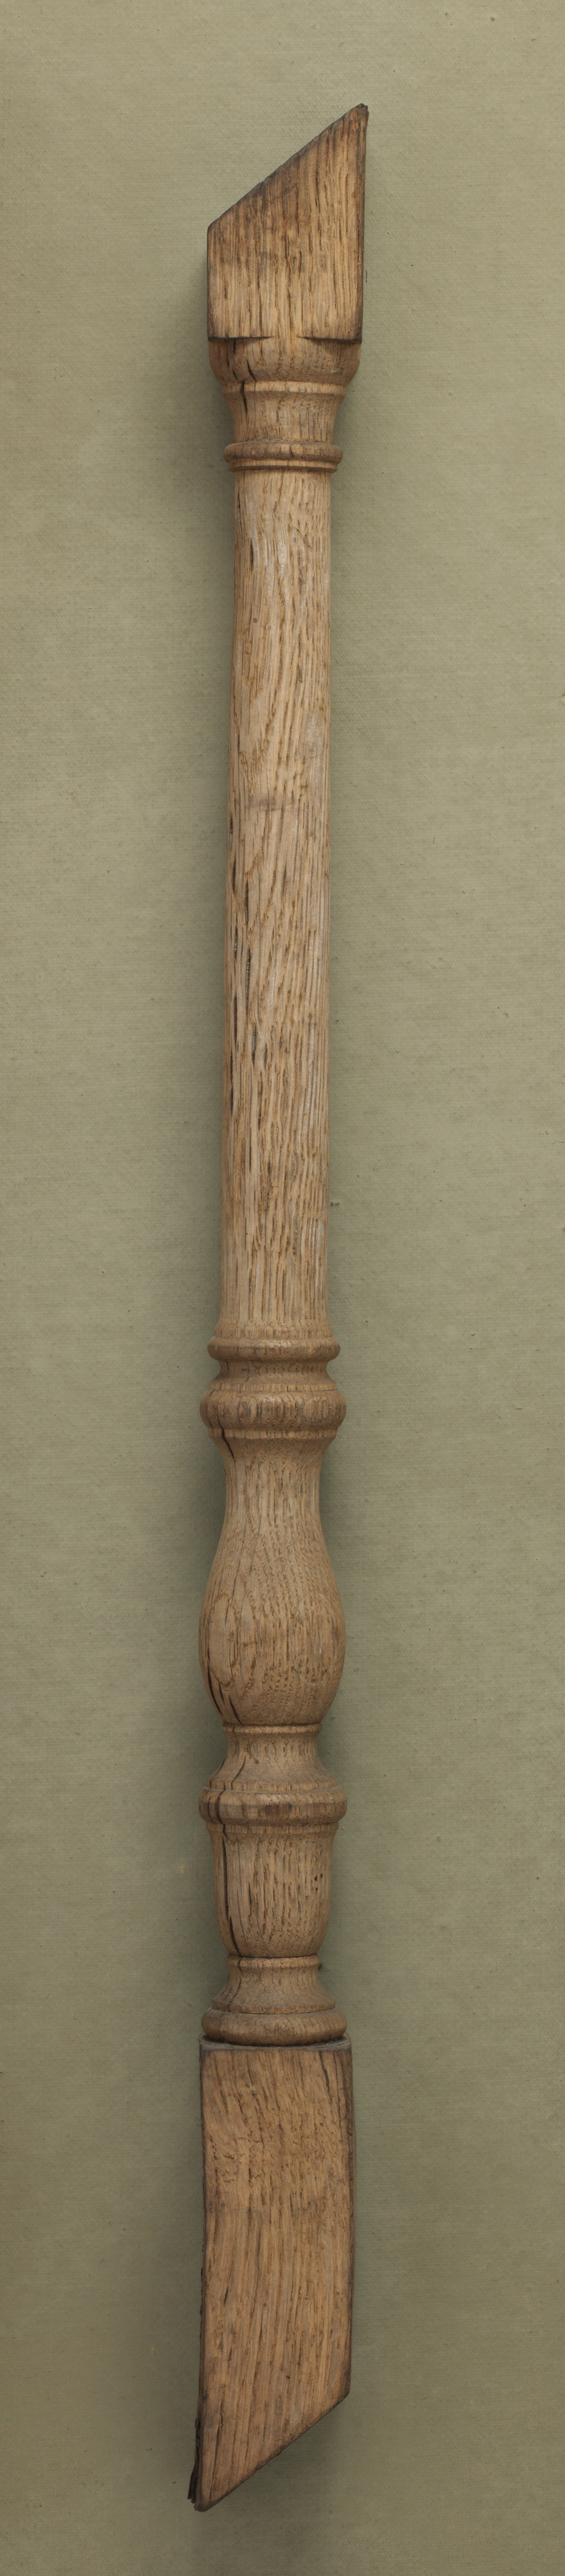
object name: baluster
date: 1701-1750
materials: wood